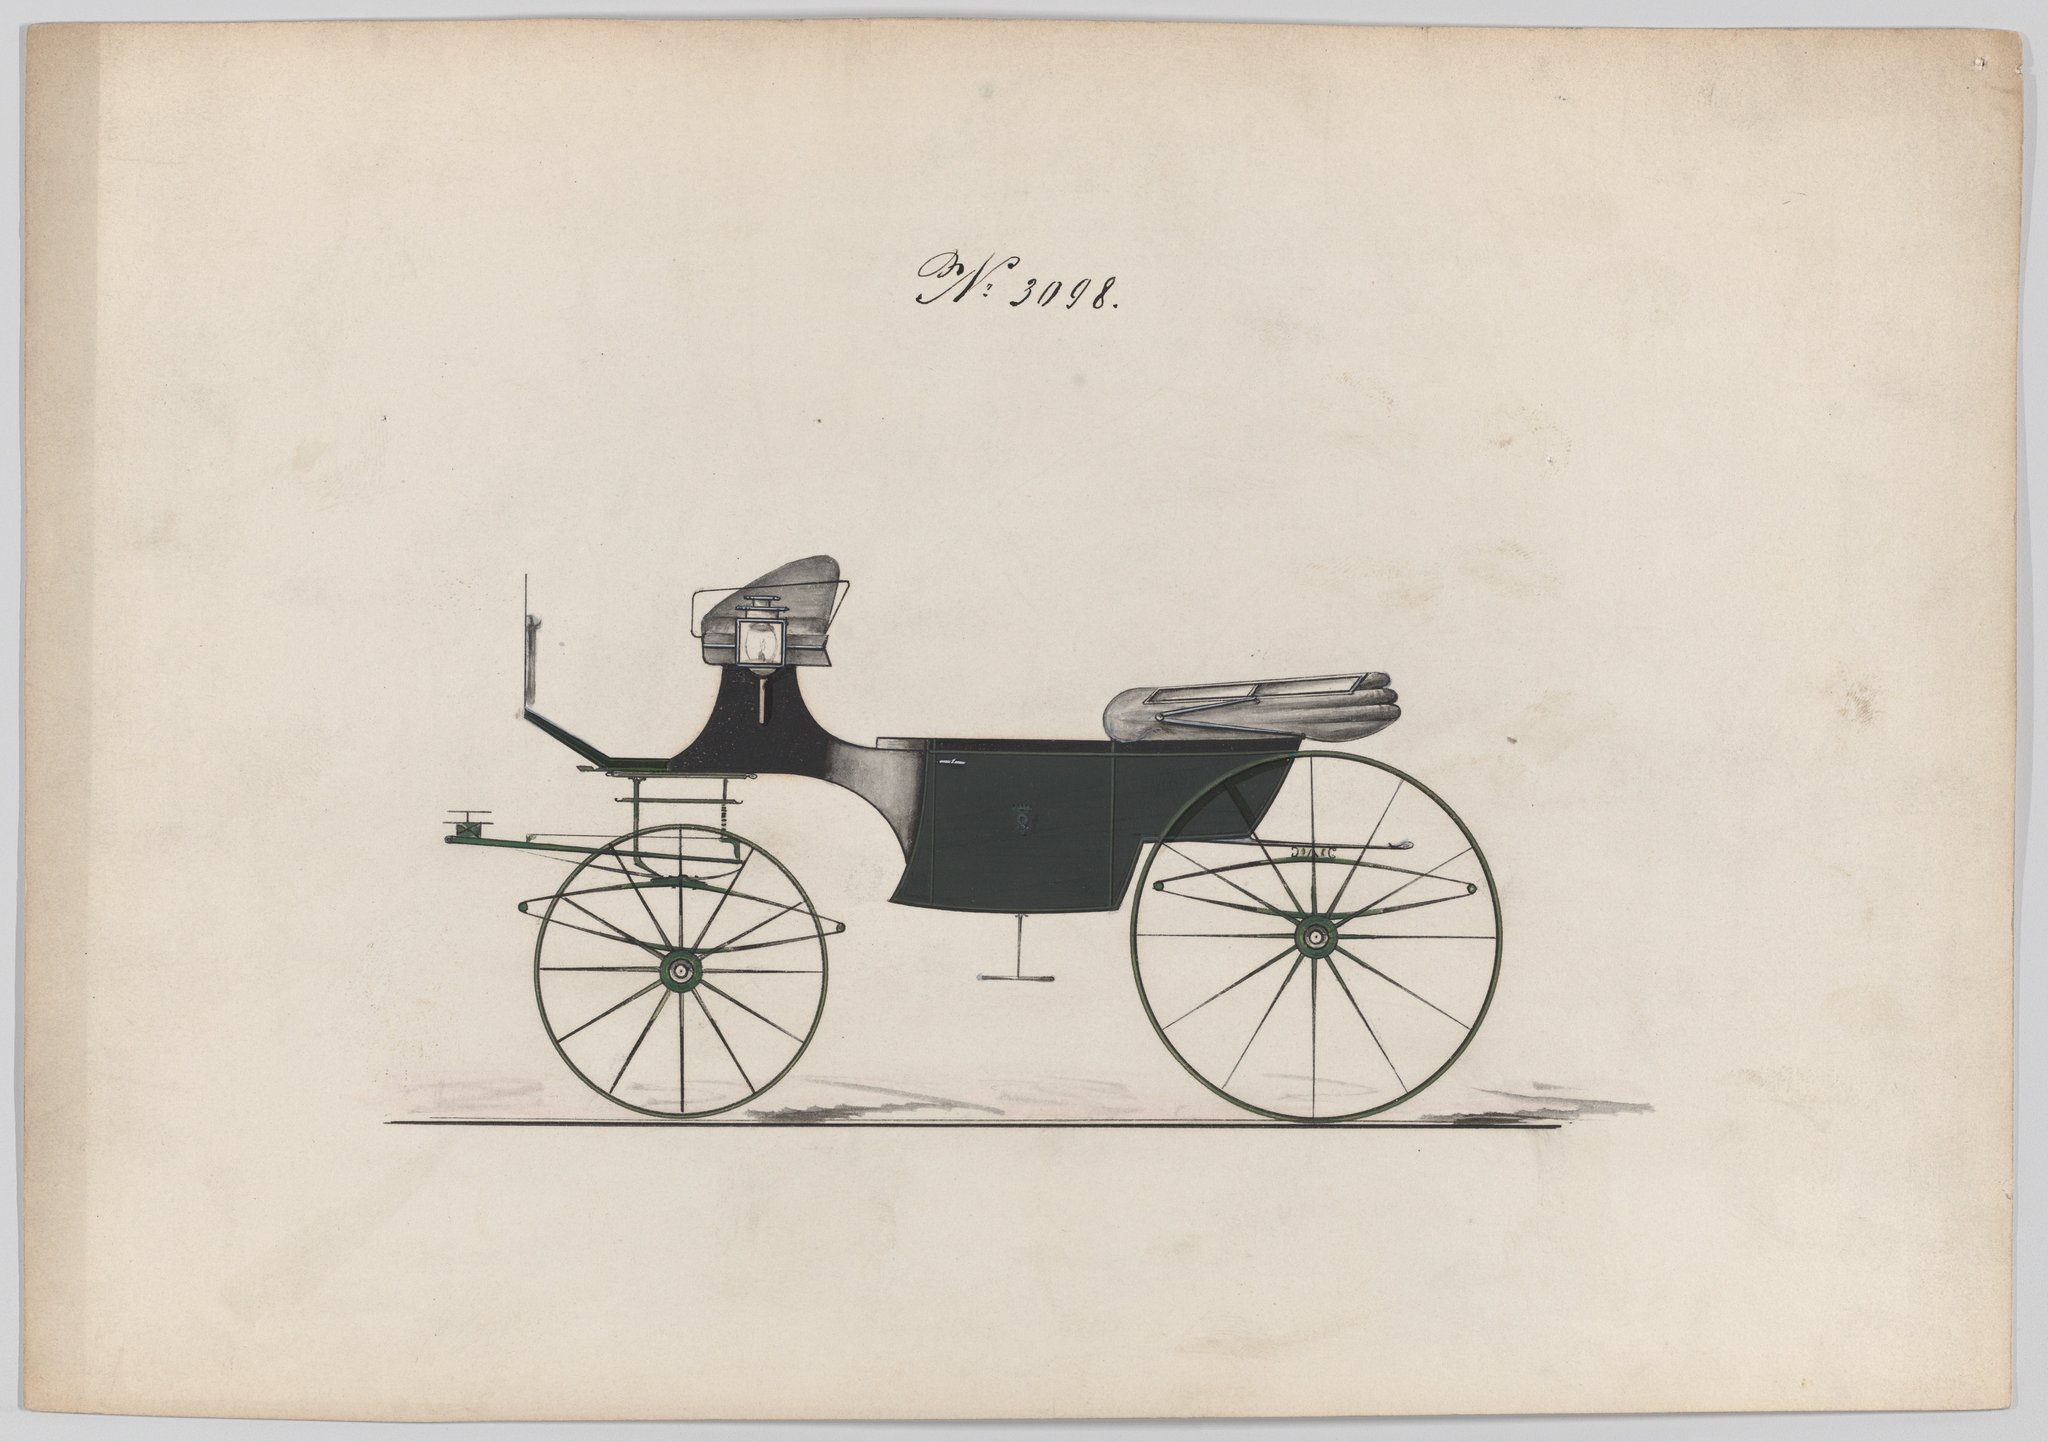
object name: drawing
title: Design for Landaulet, no. 3098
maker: brewster & co.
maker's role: manufacturer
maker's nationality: american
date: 1875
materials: gouache, gum arabic, ink, watercolor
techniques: pen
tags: carriages